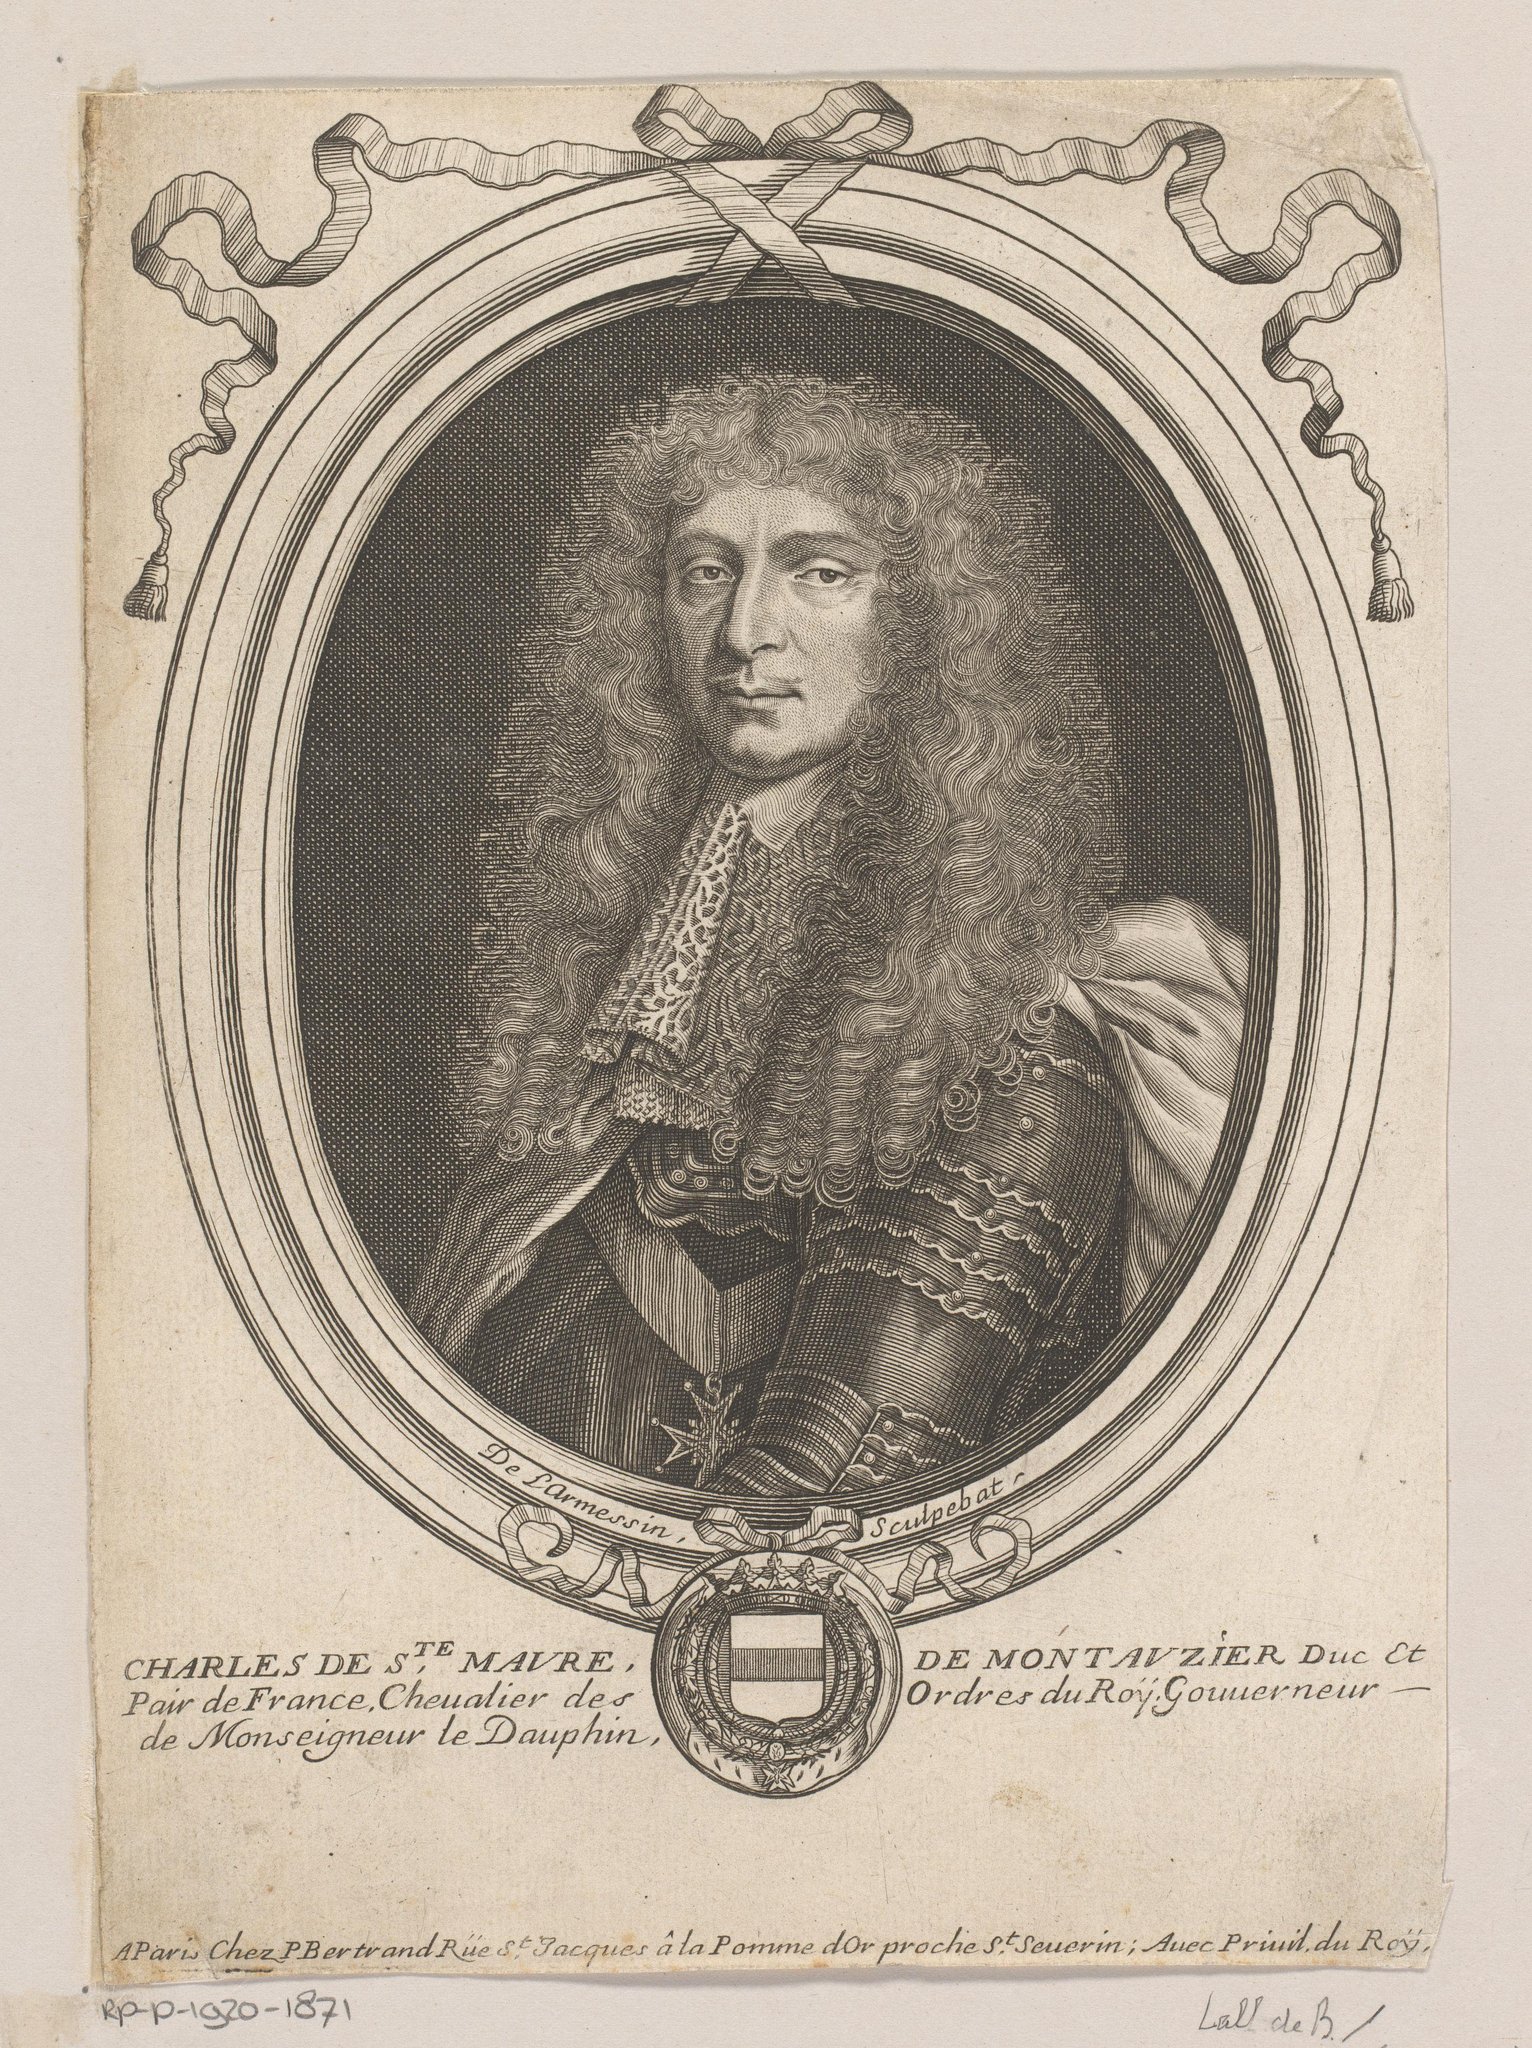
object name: print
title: Portretten van prominente figuren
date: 1642-1678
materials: paper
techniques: engraving, etching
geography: paris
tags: historical persons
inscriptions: collector's mark: Lugt 2228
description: Maakt deel uit van een grootschalige serie met portretten van prominente figuren. Binnen de serie bevindt zich een sectie getiteld 'Les Augustes Représentations De tous les Roys De France depuis Pharamond Iusqu'à Louys XIIII'. De serie werd respectievelijk uitgegeven door Pierre Bertrand, door zijn weduwe en door De Larmessin zelf.